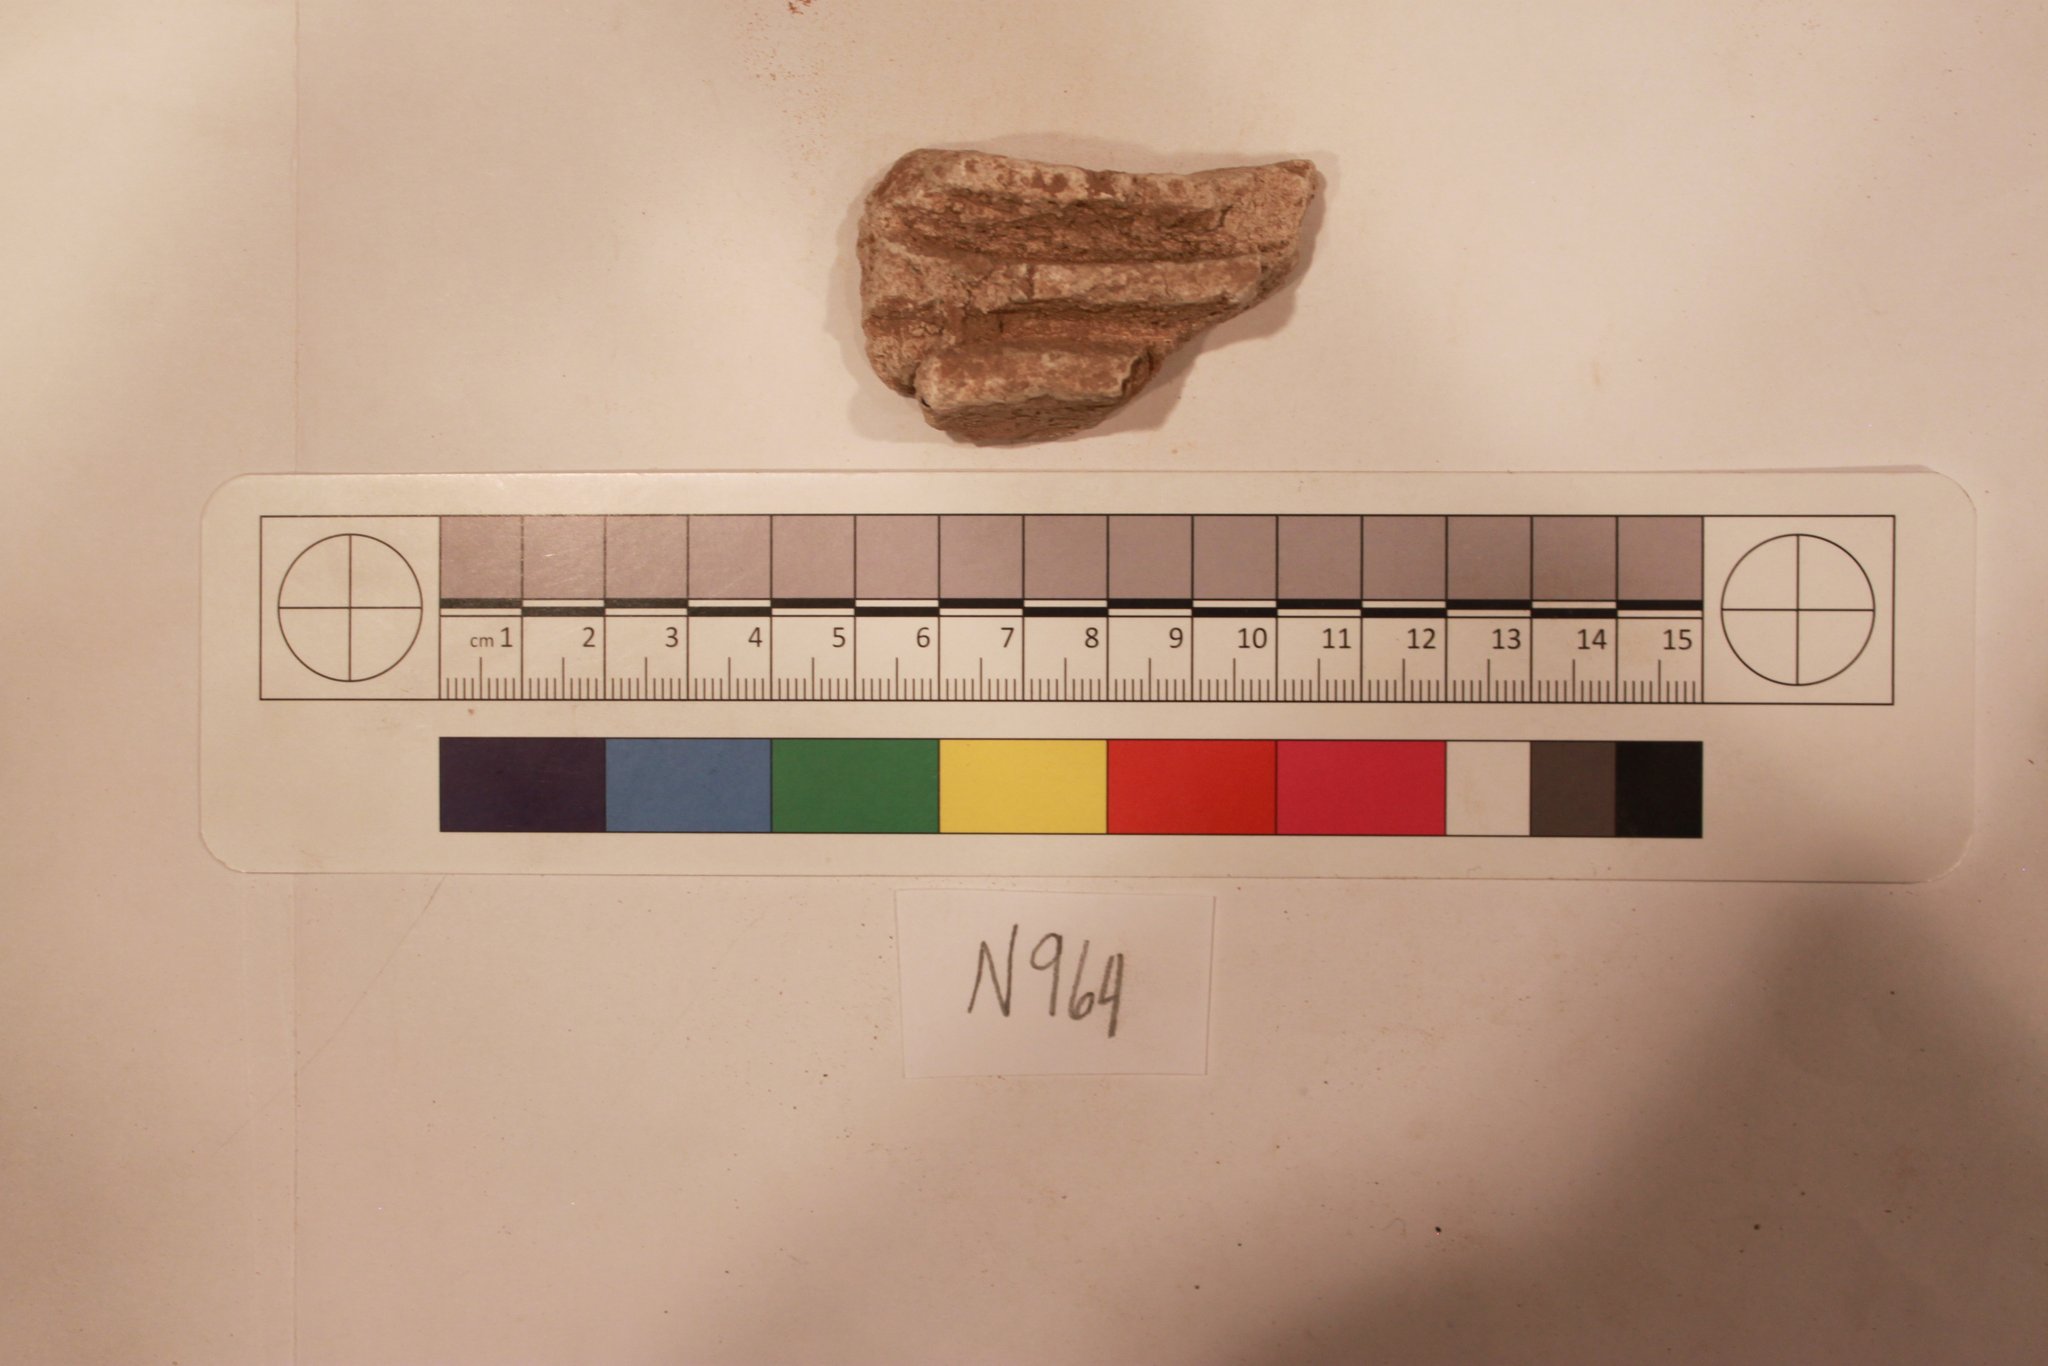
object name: fragment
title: Stucco Fragment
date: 701-1200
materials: plaster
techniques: carving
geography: iran